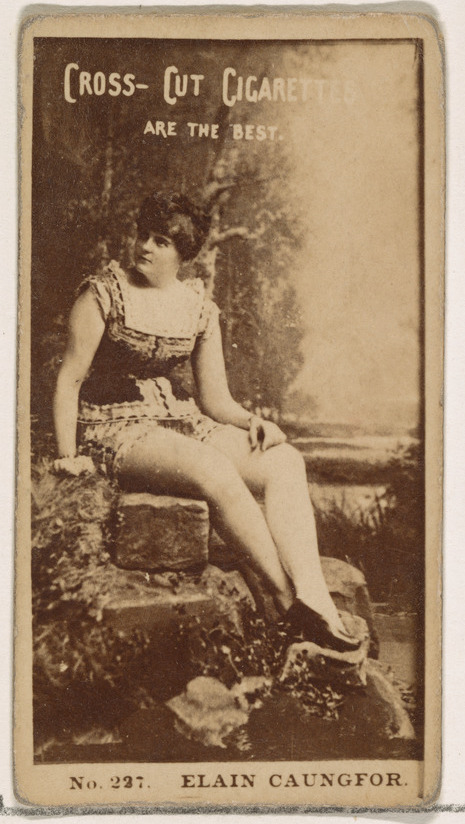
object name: print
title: Card Number 227, Elain Caungfor, from the Actors and Actresses series (N145-2) issued by Duke Sons & Co. to promote Cross Cut Cigarettes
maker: w. duke, sons & co.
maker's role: publisher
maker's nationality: american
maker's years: 1870-1920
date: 1880-1889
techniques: albumen silver print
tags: portraits,women,actresses